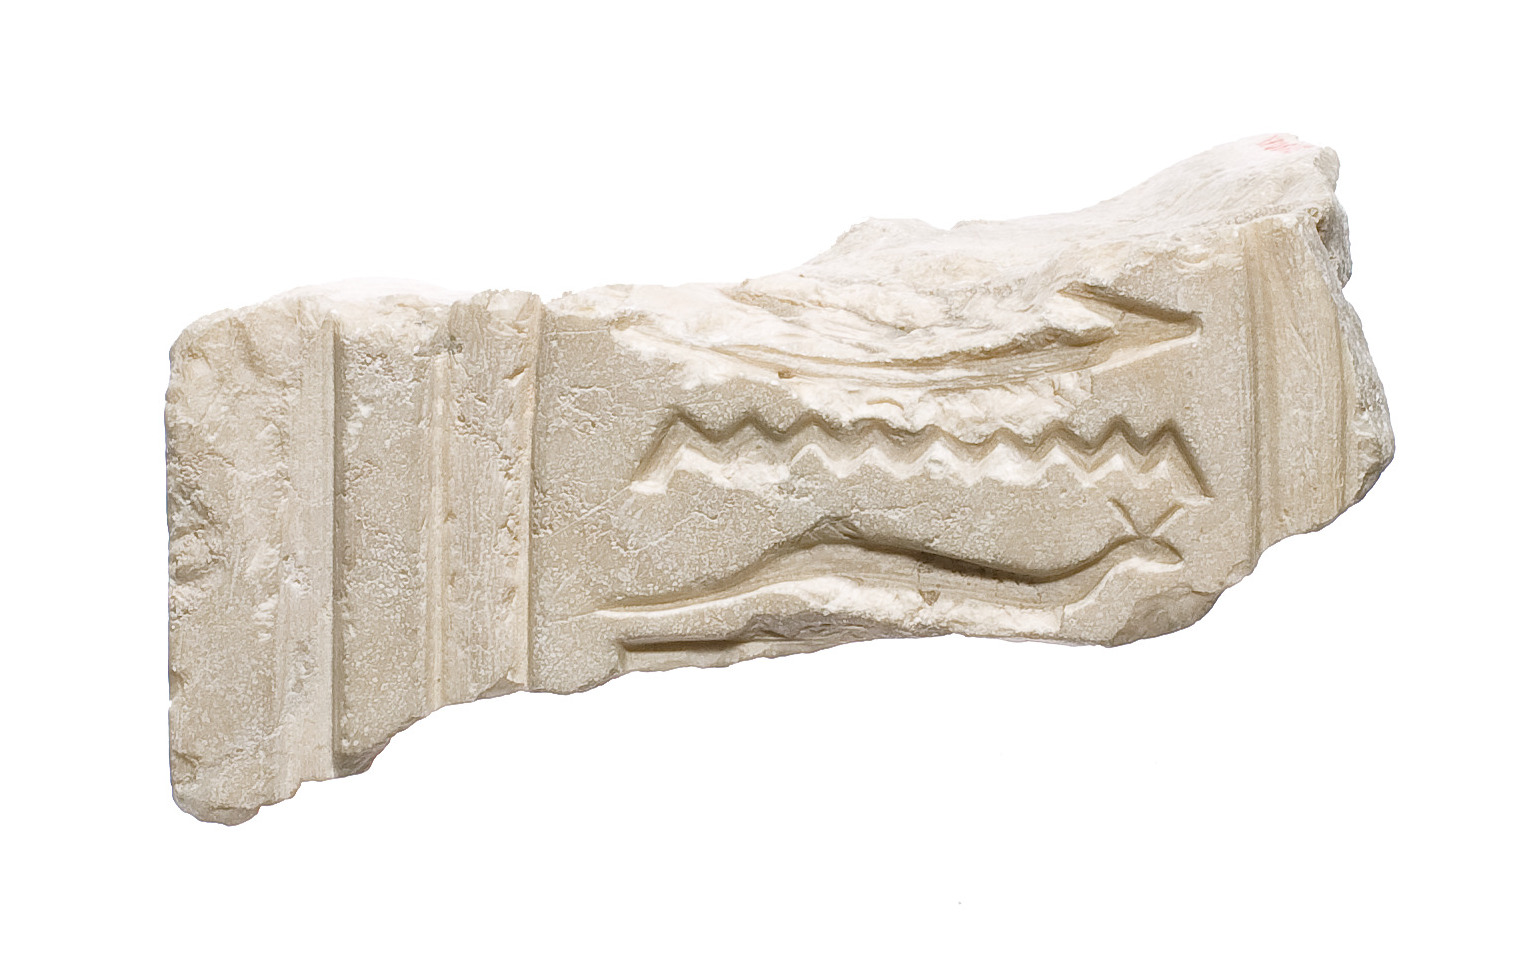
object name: back pillar, aten cartouch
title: Back pillar (?), Aten cartouches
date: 1353-1336 BCE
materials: limestone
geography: egypt